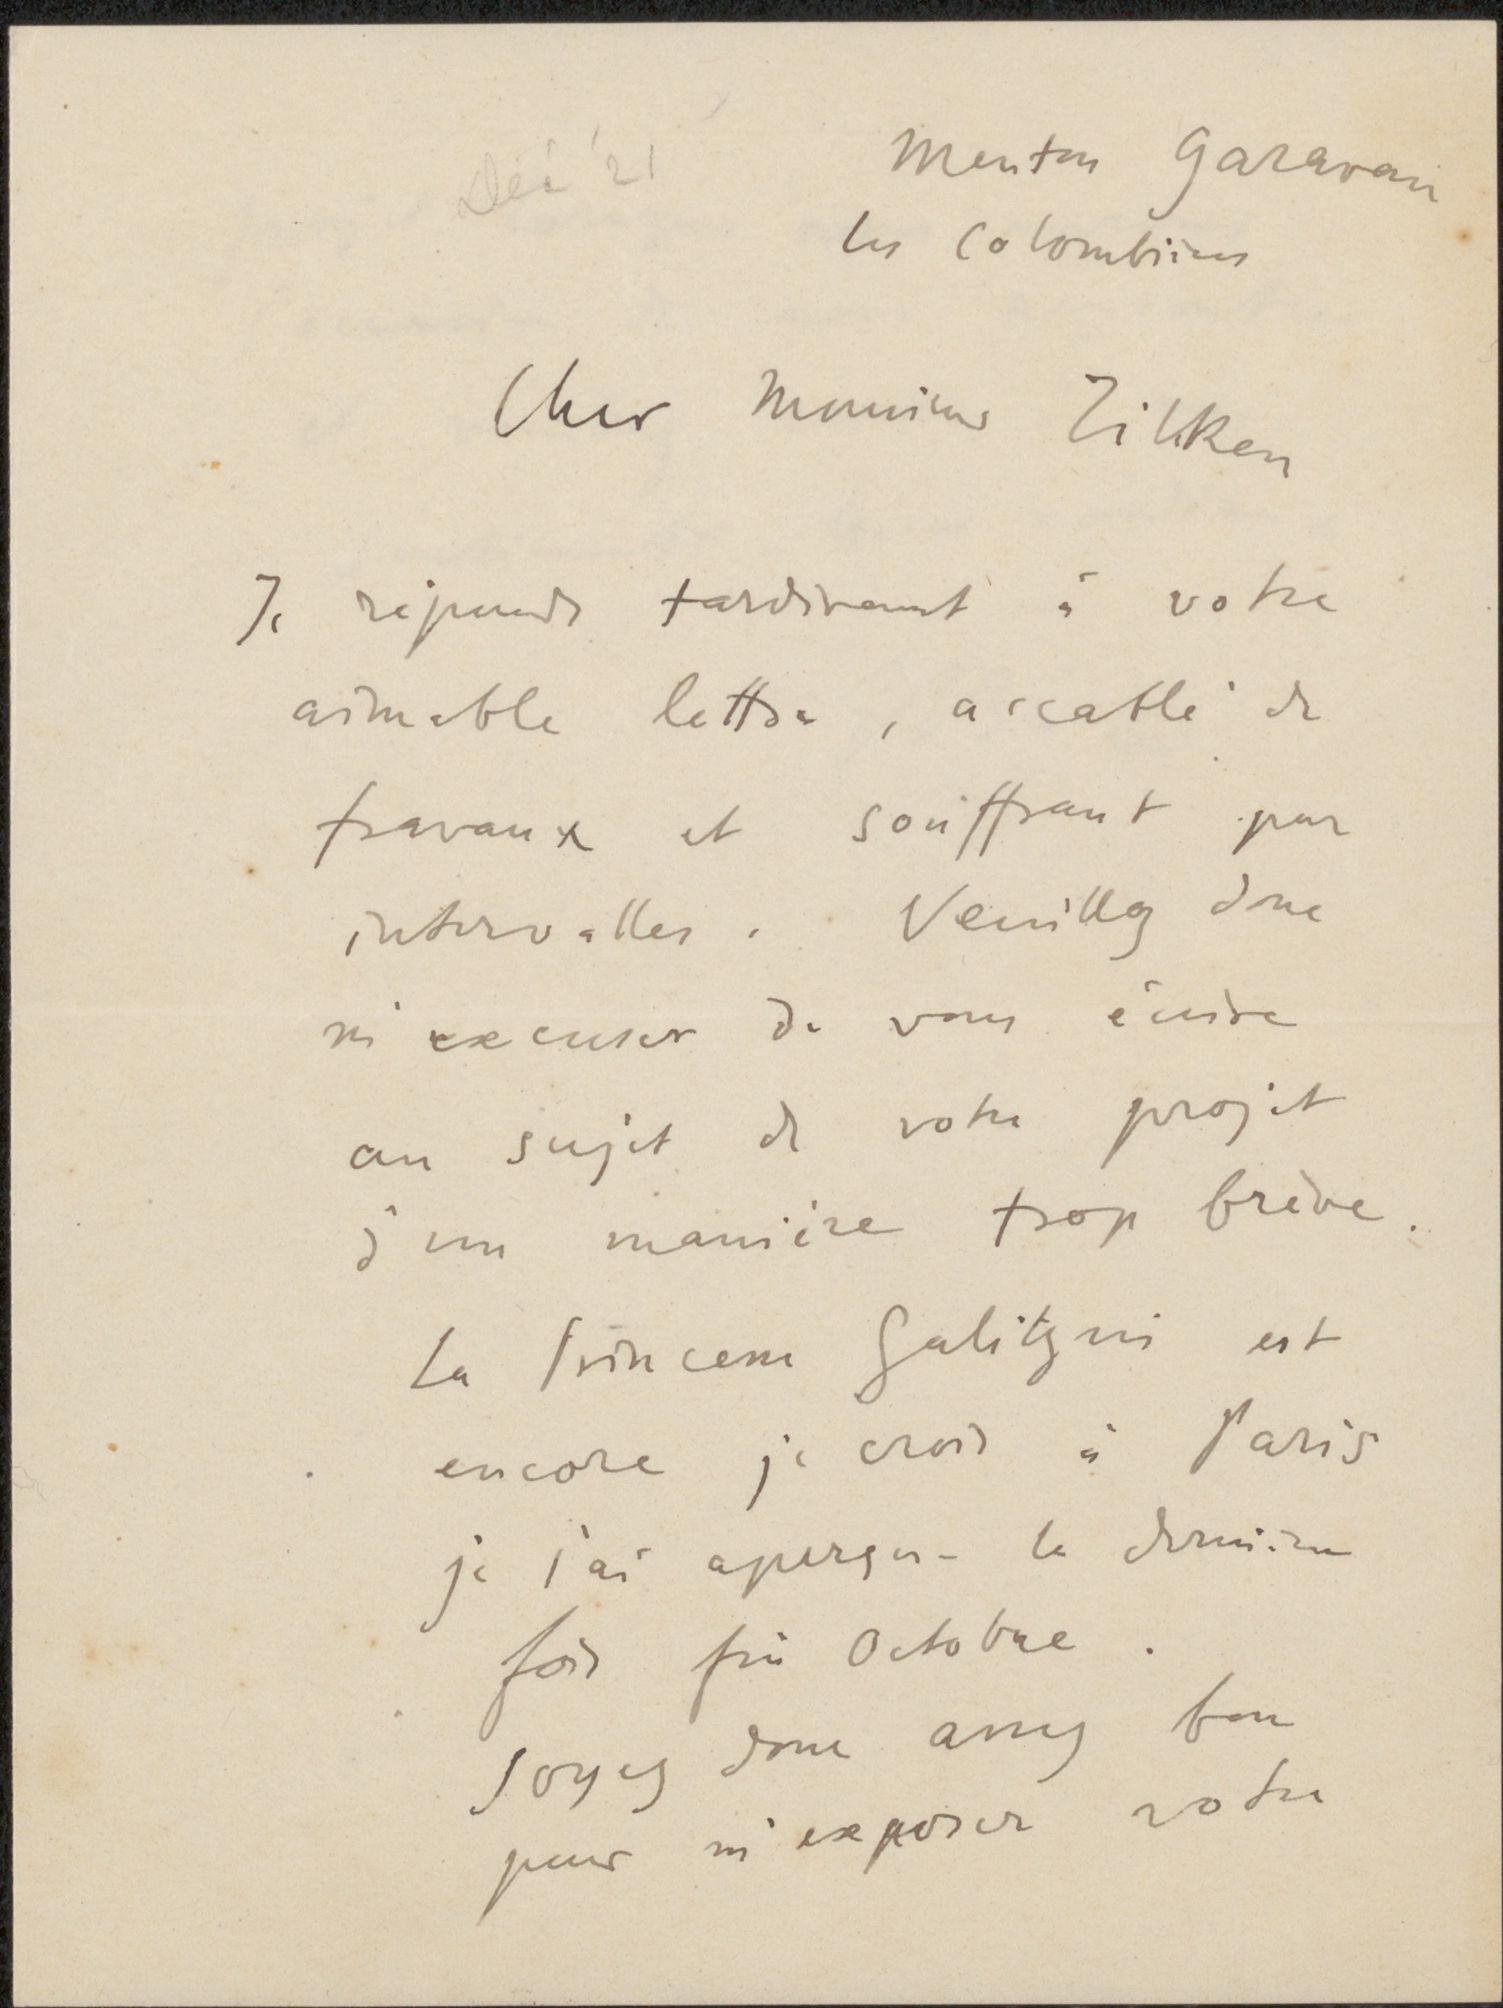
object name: letter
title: Brief aan Philip Zilcken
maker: ferdinand-sigismund bac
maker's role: draughtsman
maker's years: 1859-1952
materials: ink, paper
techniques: pen, writing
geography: menton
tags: painter, draughtsman, philip zilcken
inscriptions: collector's mark: ‘RPK’